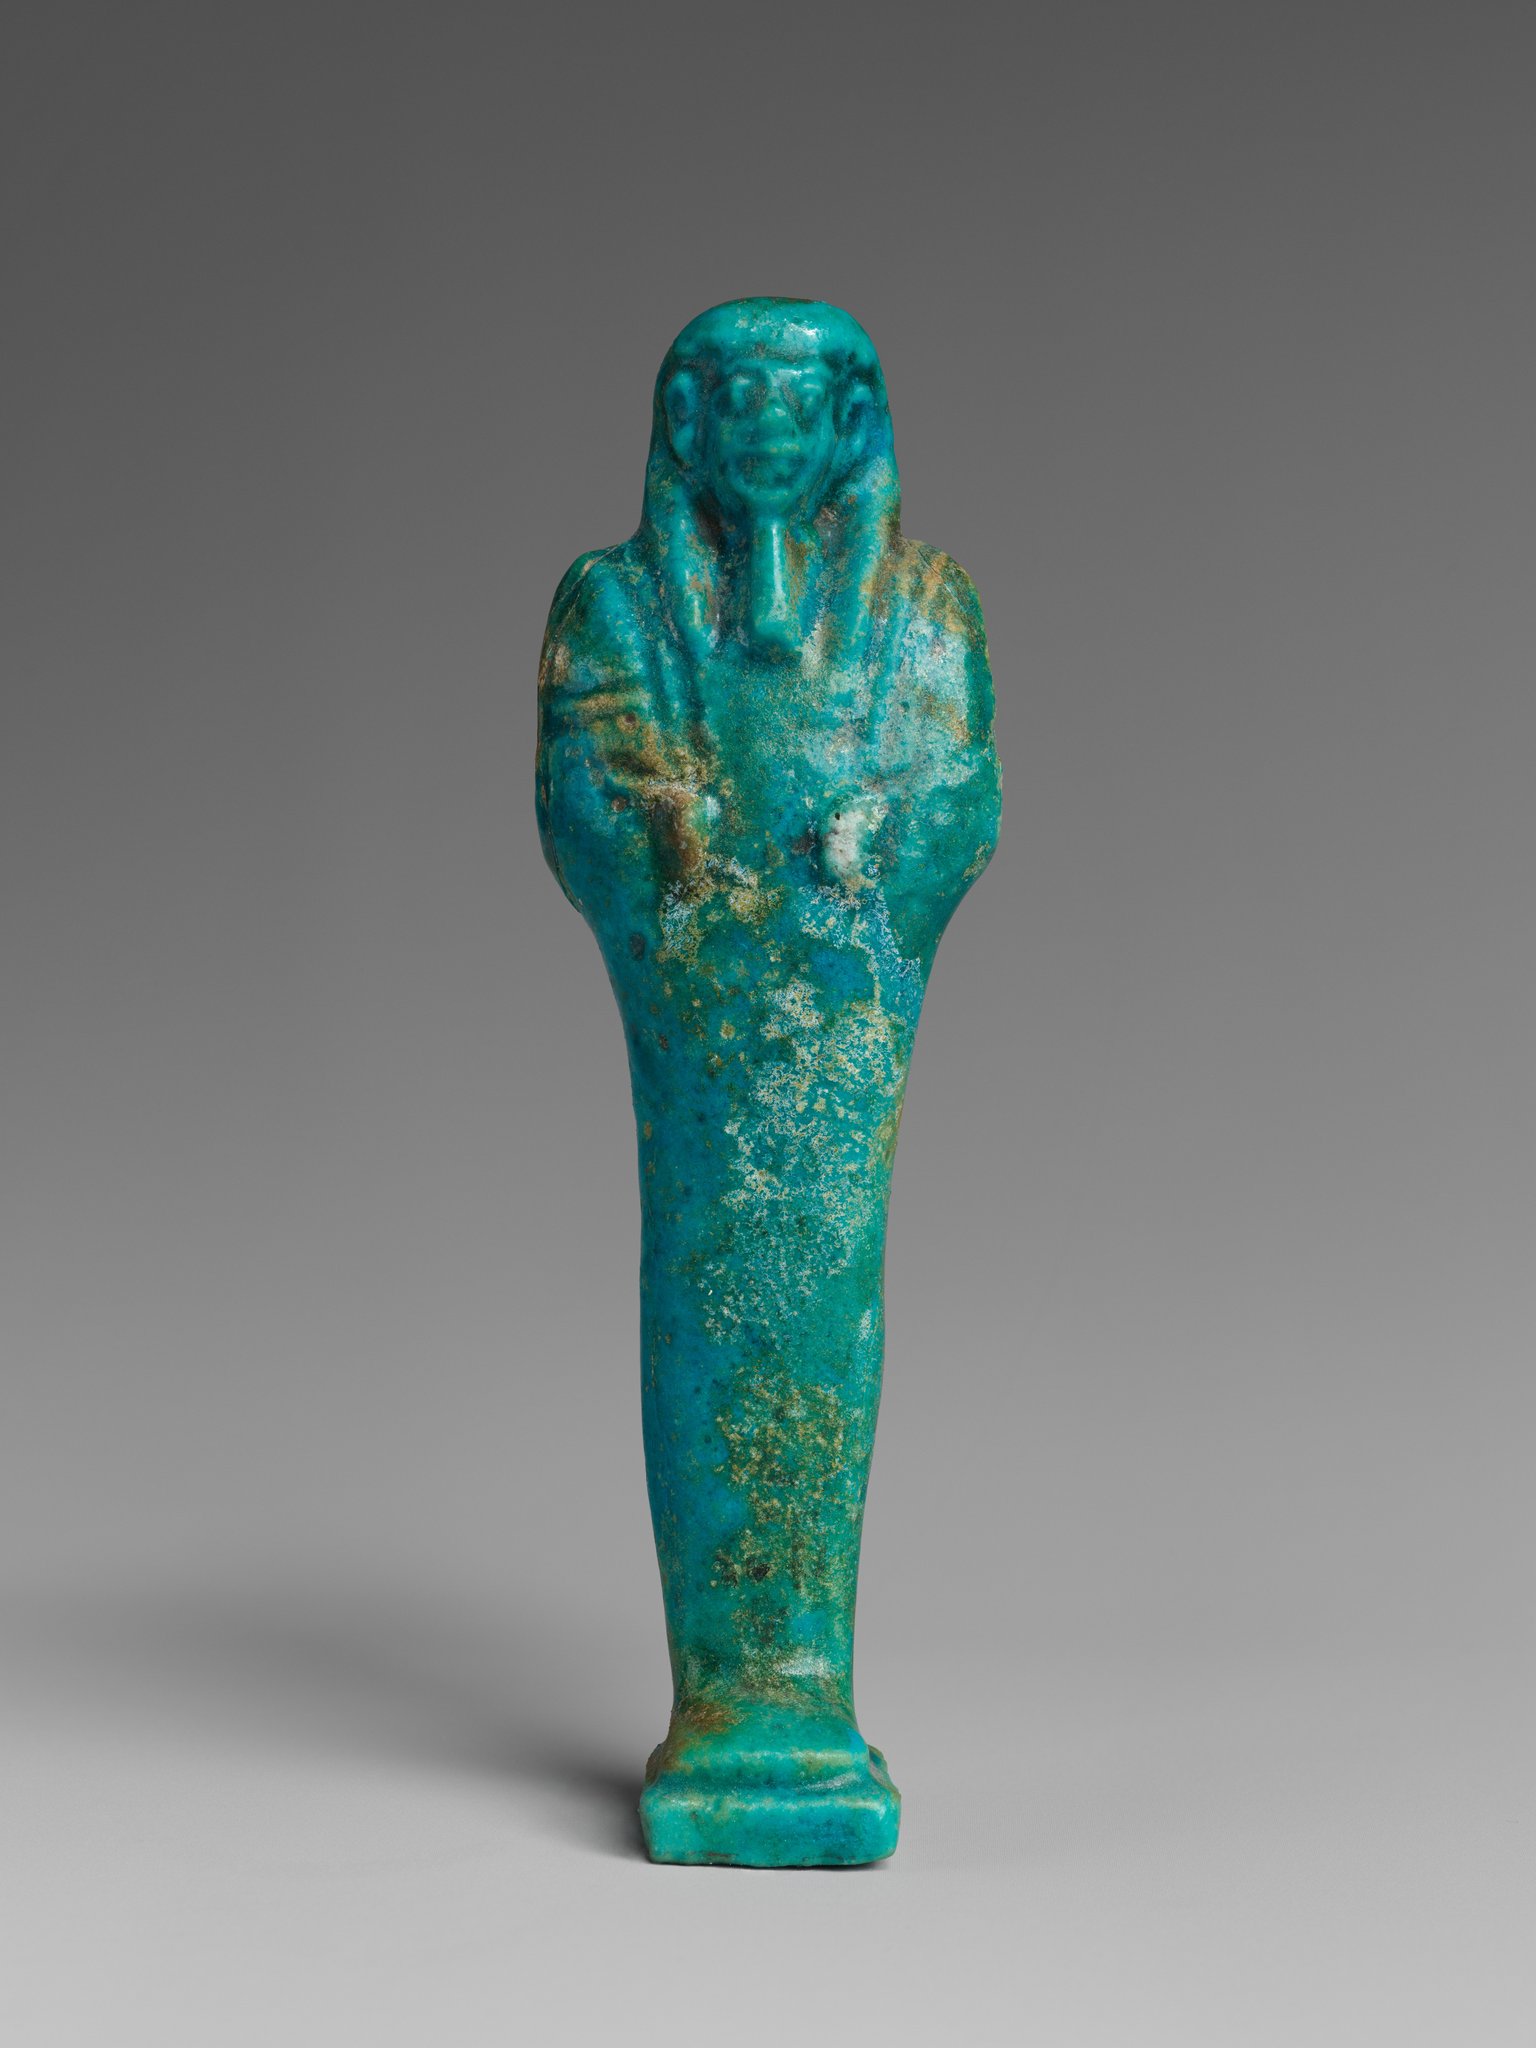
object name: shabti, djedhor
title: Shabti of Djedhor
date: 360-300 BCE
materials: faience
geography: egypt